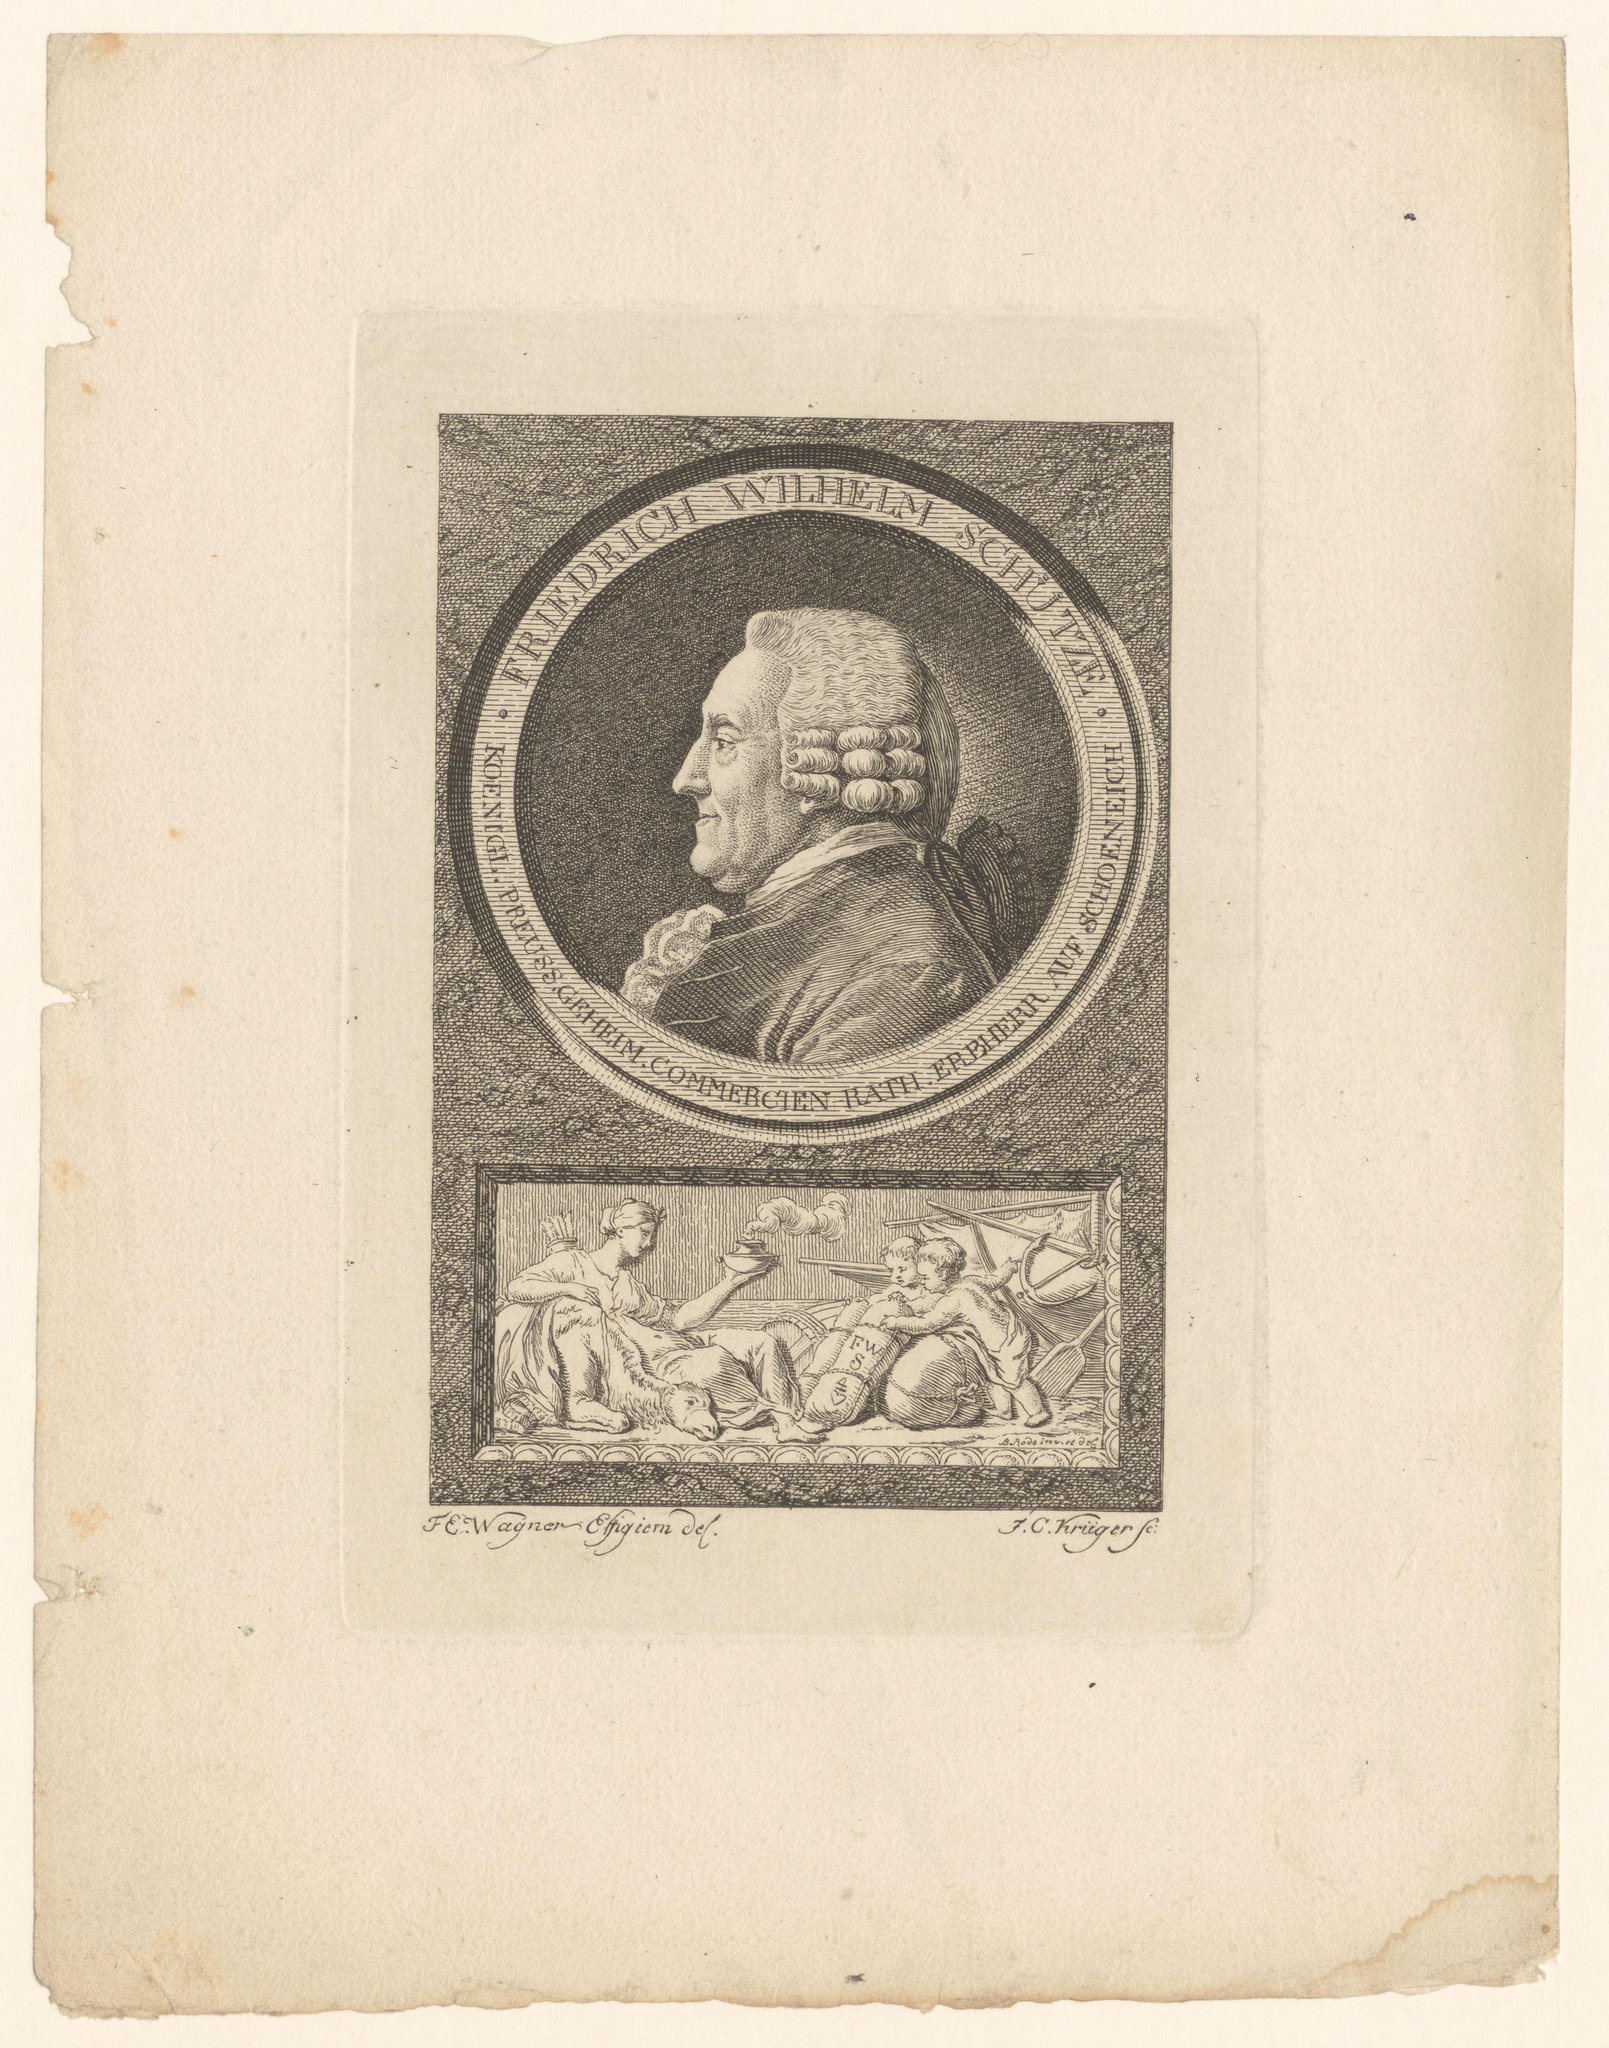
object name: print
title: Portret van Friedrich Wilhelm Schütze met allegorie op de handel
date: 1743-1791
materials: paper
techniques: engraving, etching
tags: economy; 'economia', 'providenza dell'annona' (ripa), historical persons, counsellor, merchant, salesman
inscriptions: collector's mark: Lugt 2228